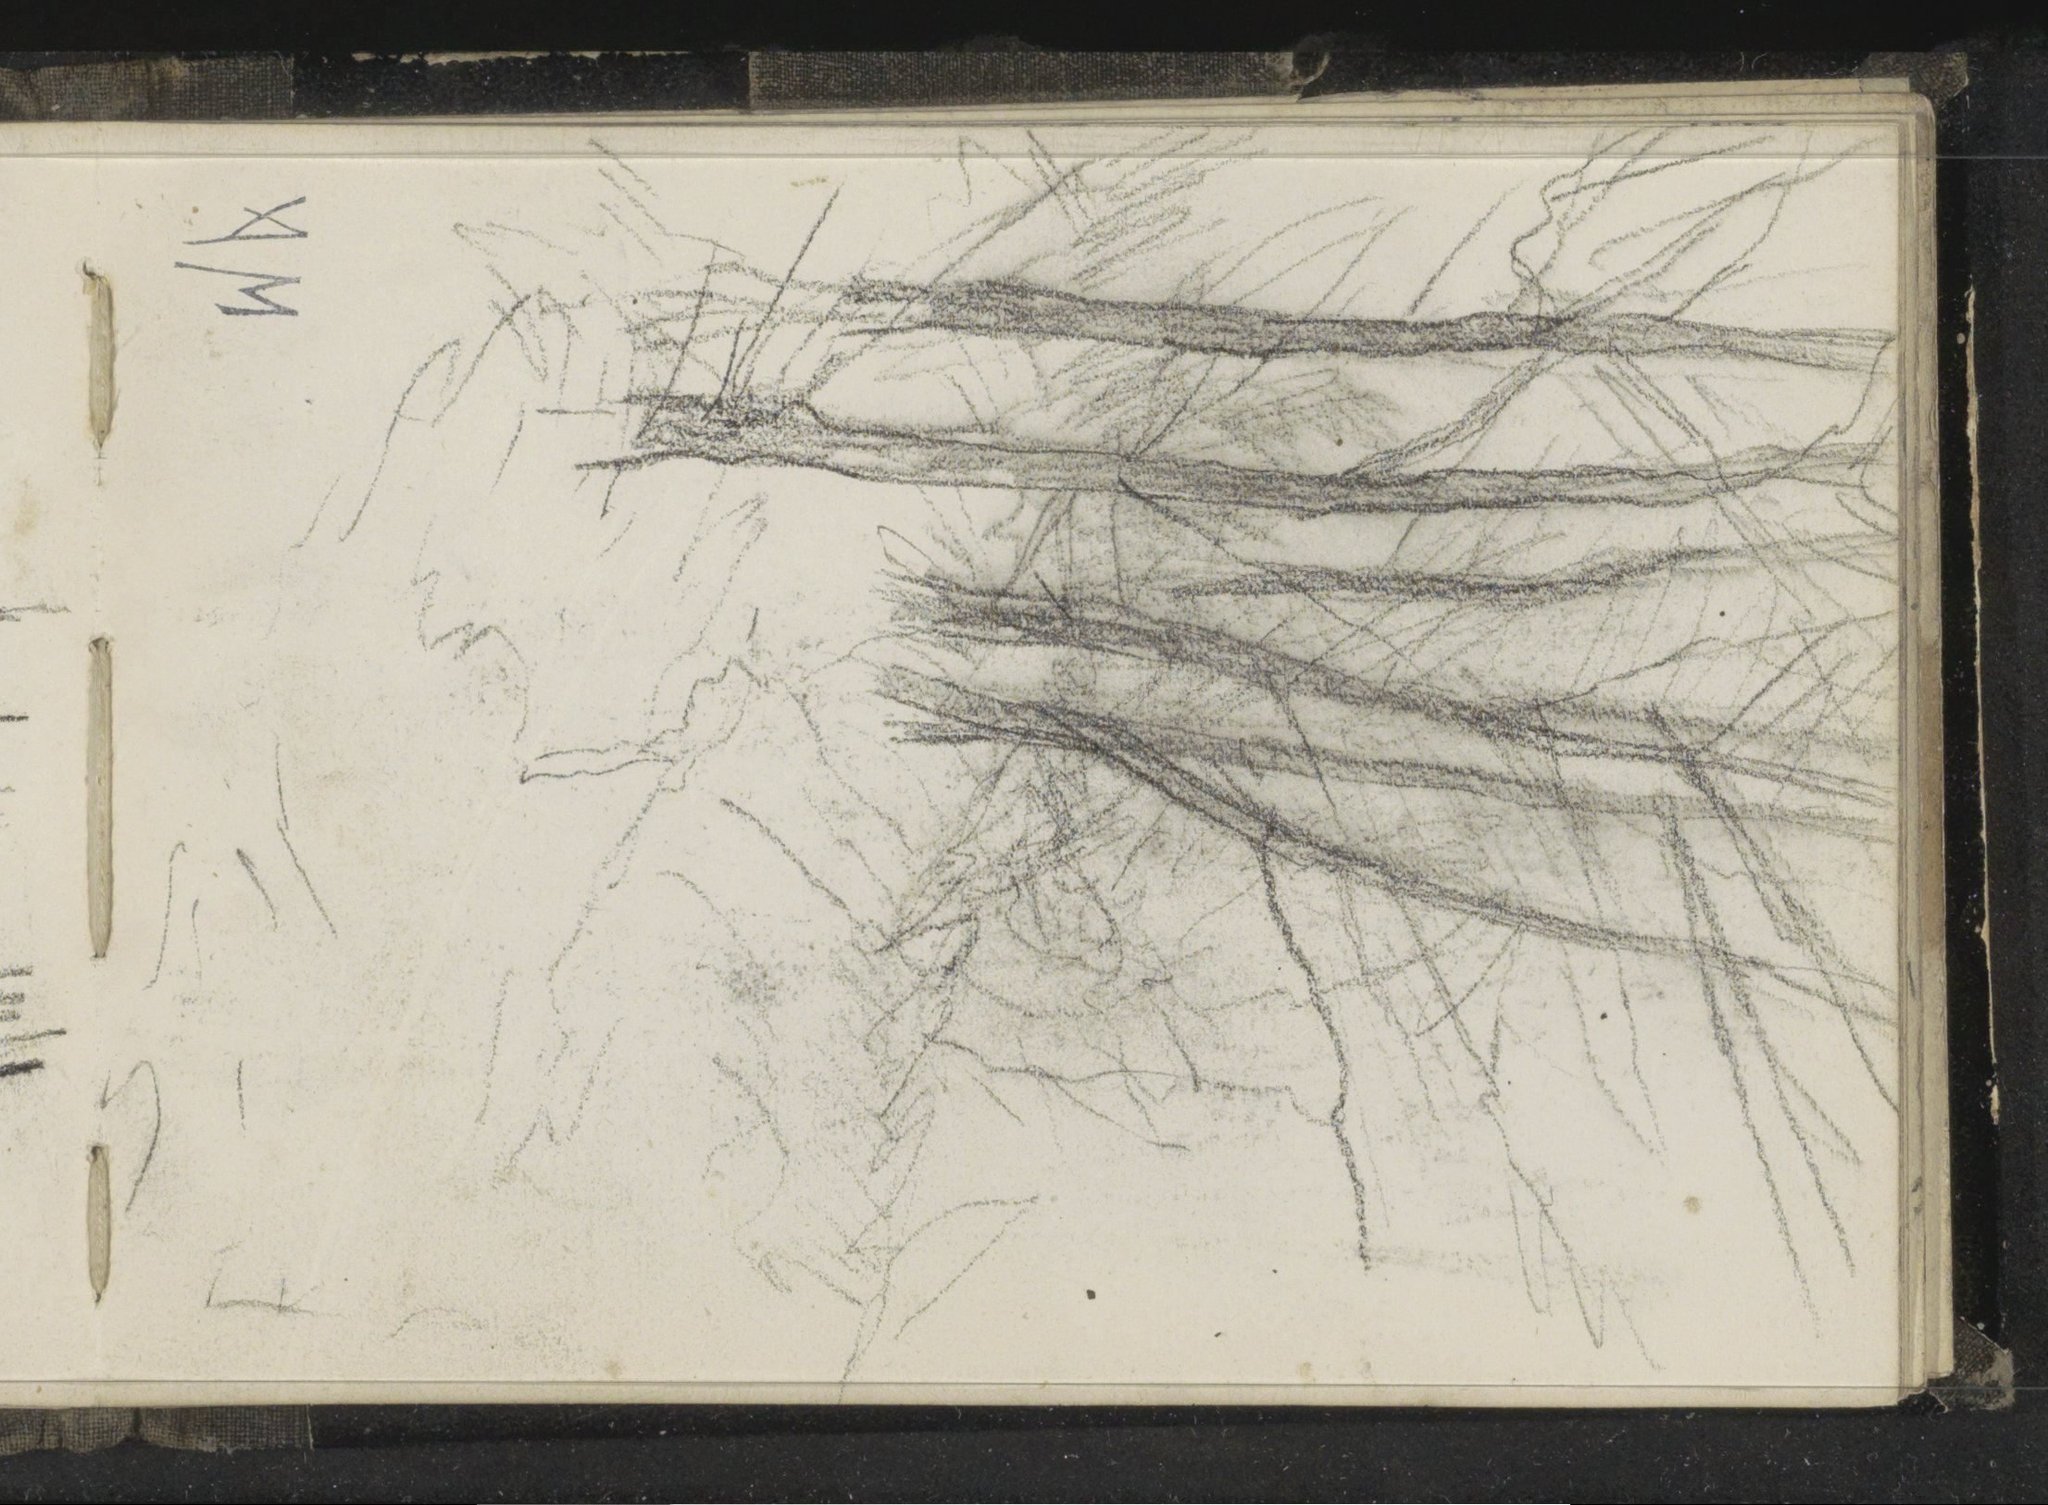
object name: sketchbook leaf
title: Bomengroep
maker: anton mauve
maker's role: draughtsman, painter, print maker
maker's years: 1838-1888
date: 1848-1888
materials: chalk, paper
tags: trees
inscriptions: monogram: ‘AM’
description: Blad 19 recto uit een schetsboek met 33 bladen.